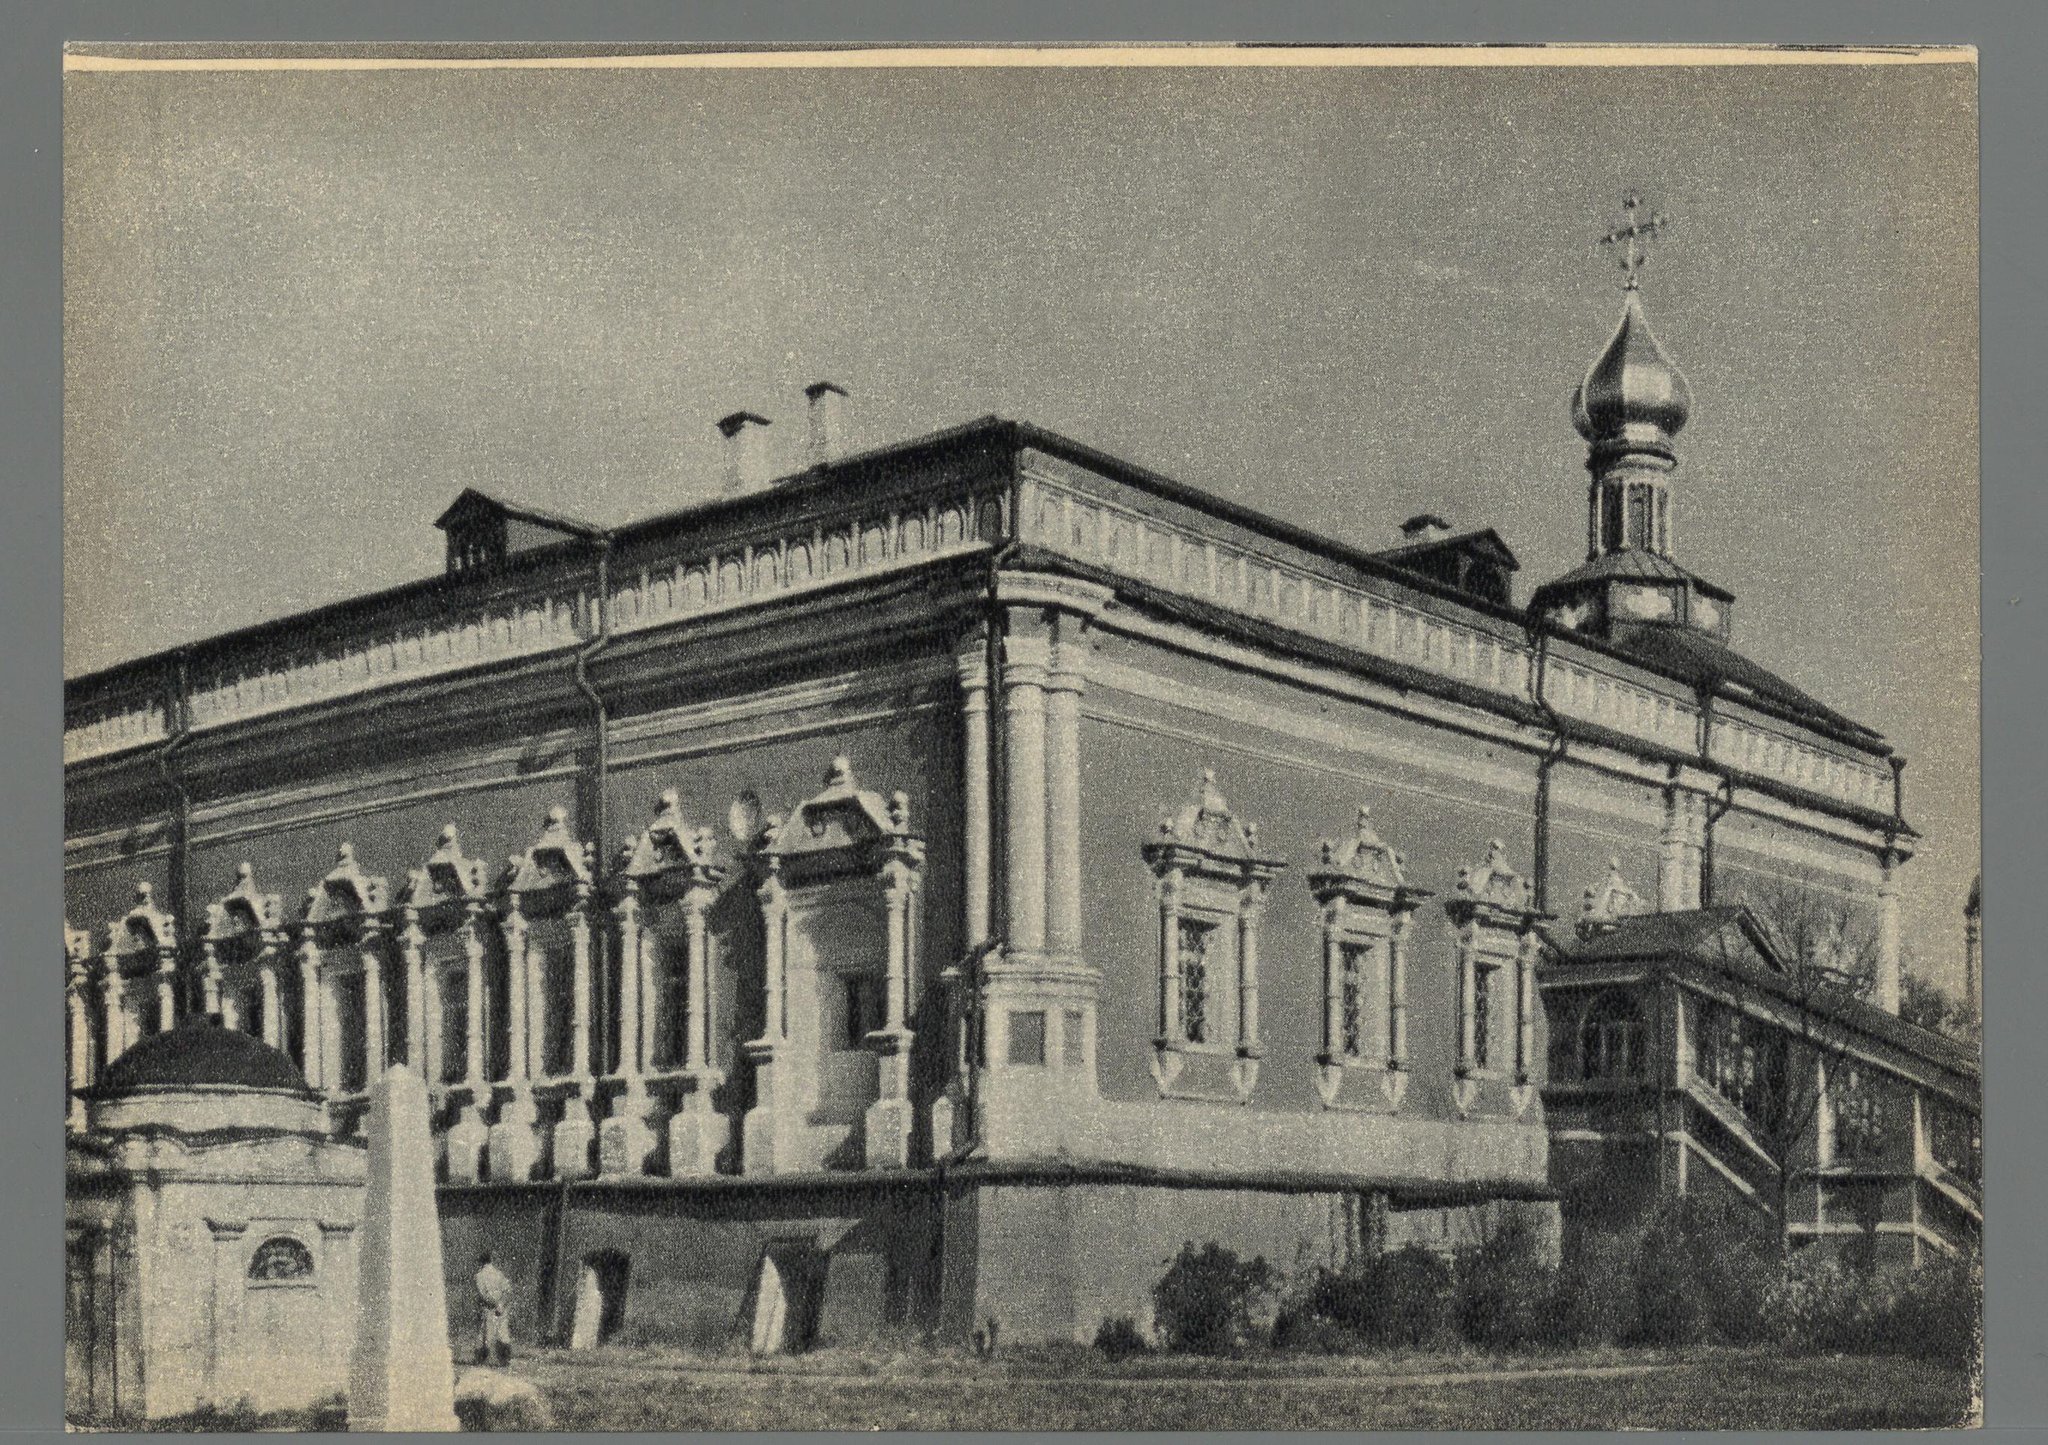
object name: photomechanical print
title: Gezicht op het Novodevitsjiklooster te Moskou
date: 1957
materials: cardboard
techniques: rotogravure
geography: moscow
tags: abbey, monastery, convent ~ roman catholic church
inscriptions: date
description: De titel op object staat in het Russisch.